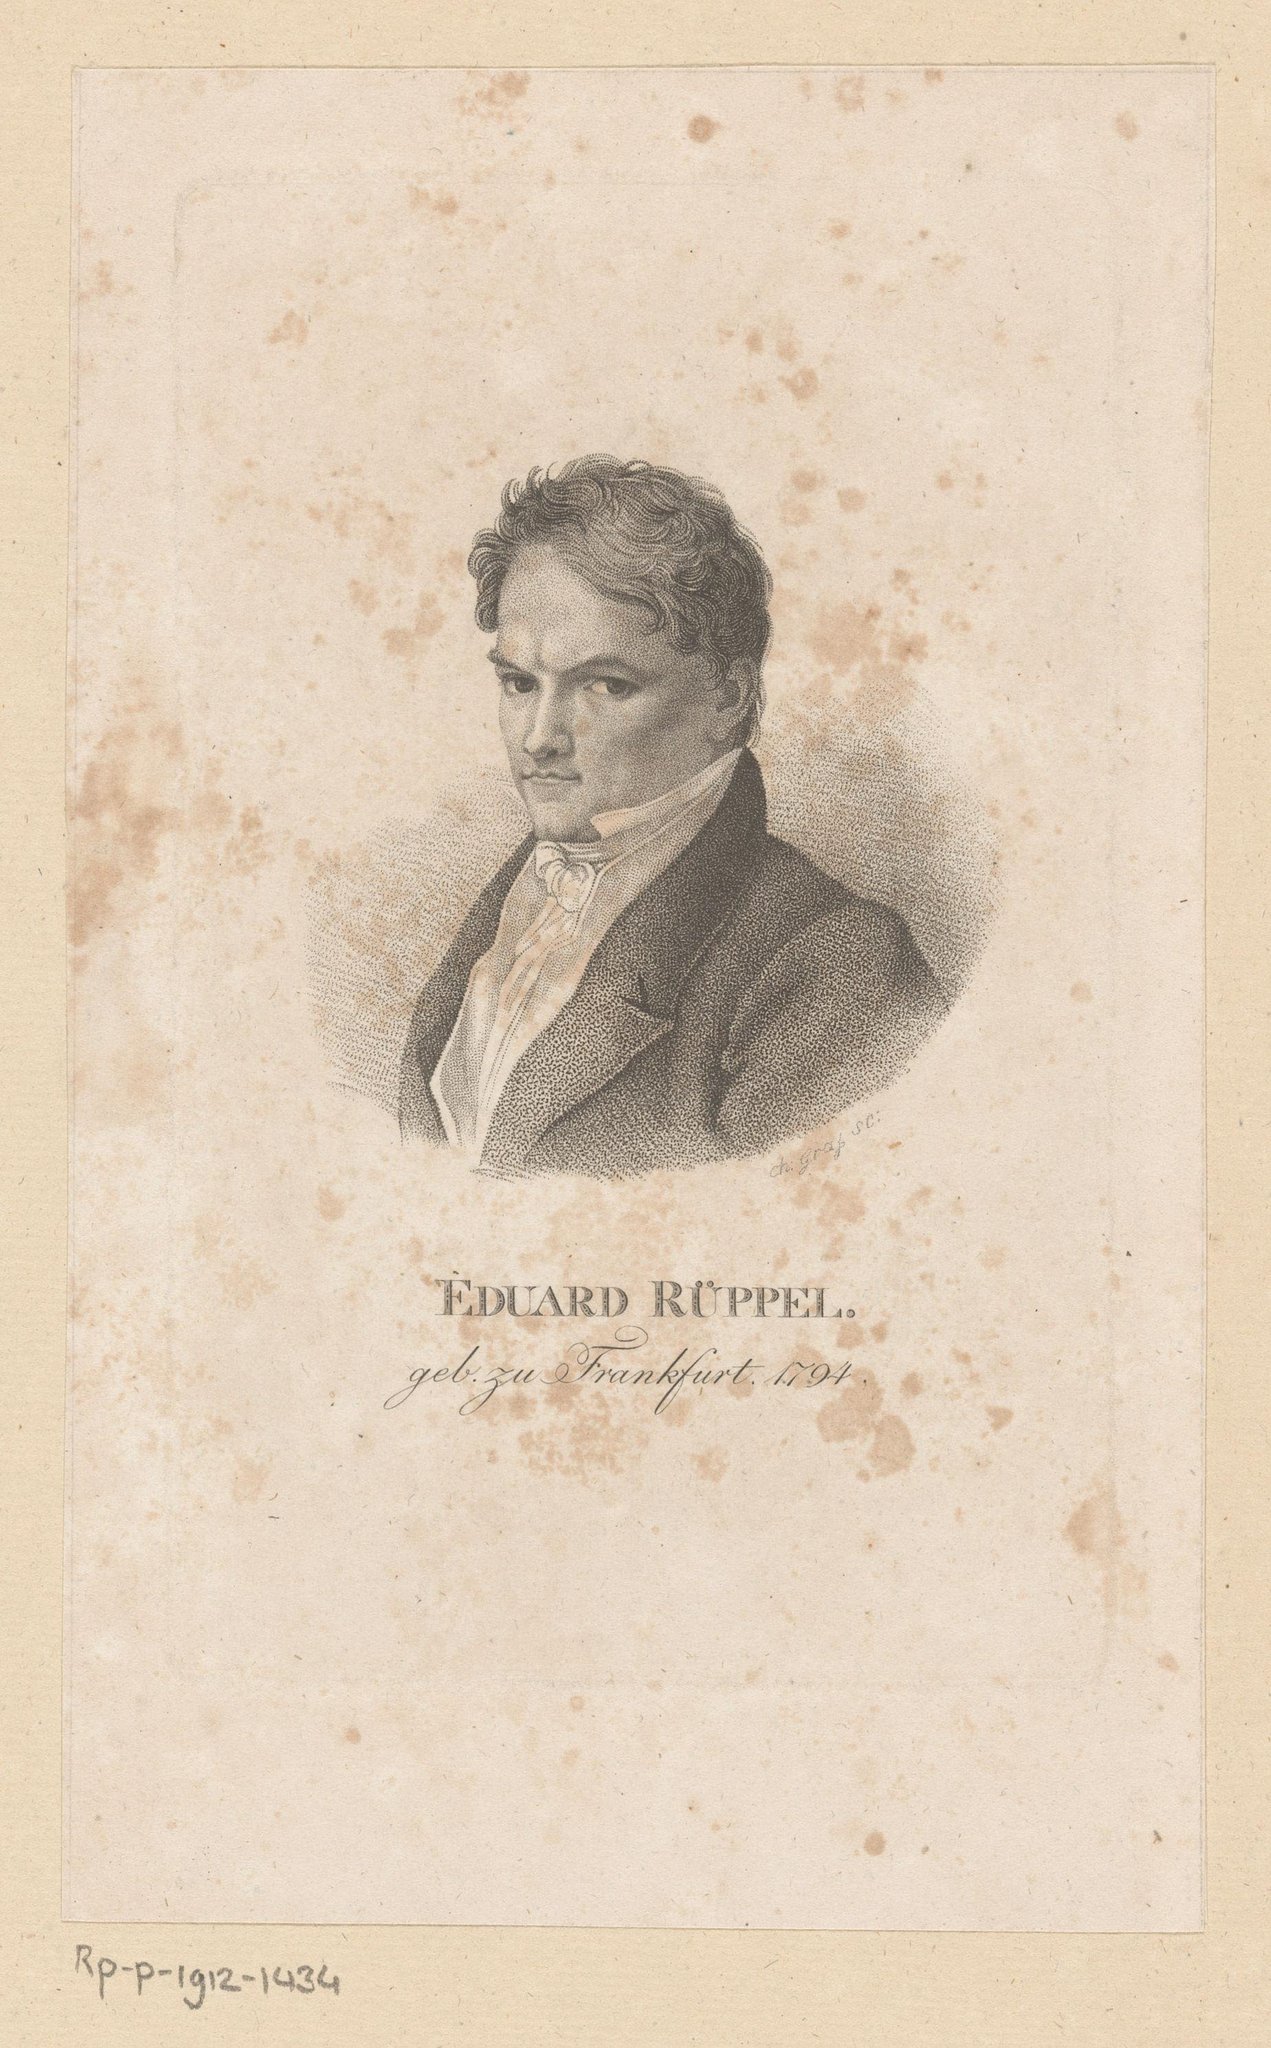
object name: print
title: Portret van Eduard Rüppell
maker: christ. graf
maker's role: print maker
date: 1804-1884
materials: paper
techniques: roulette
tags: historical persons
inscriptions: collector's mark: Lugt 2228